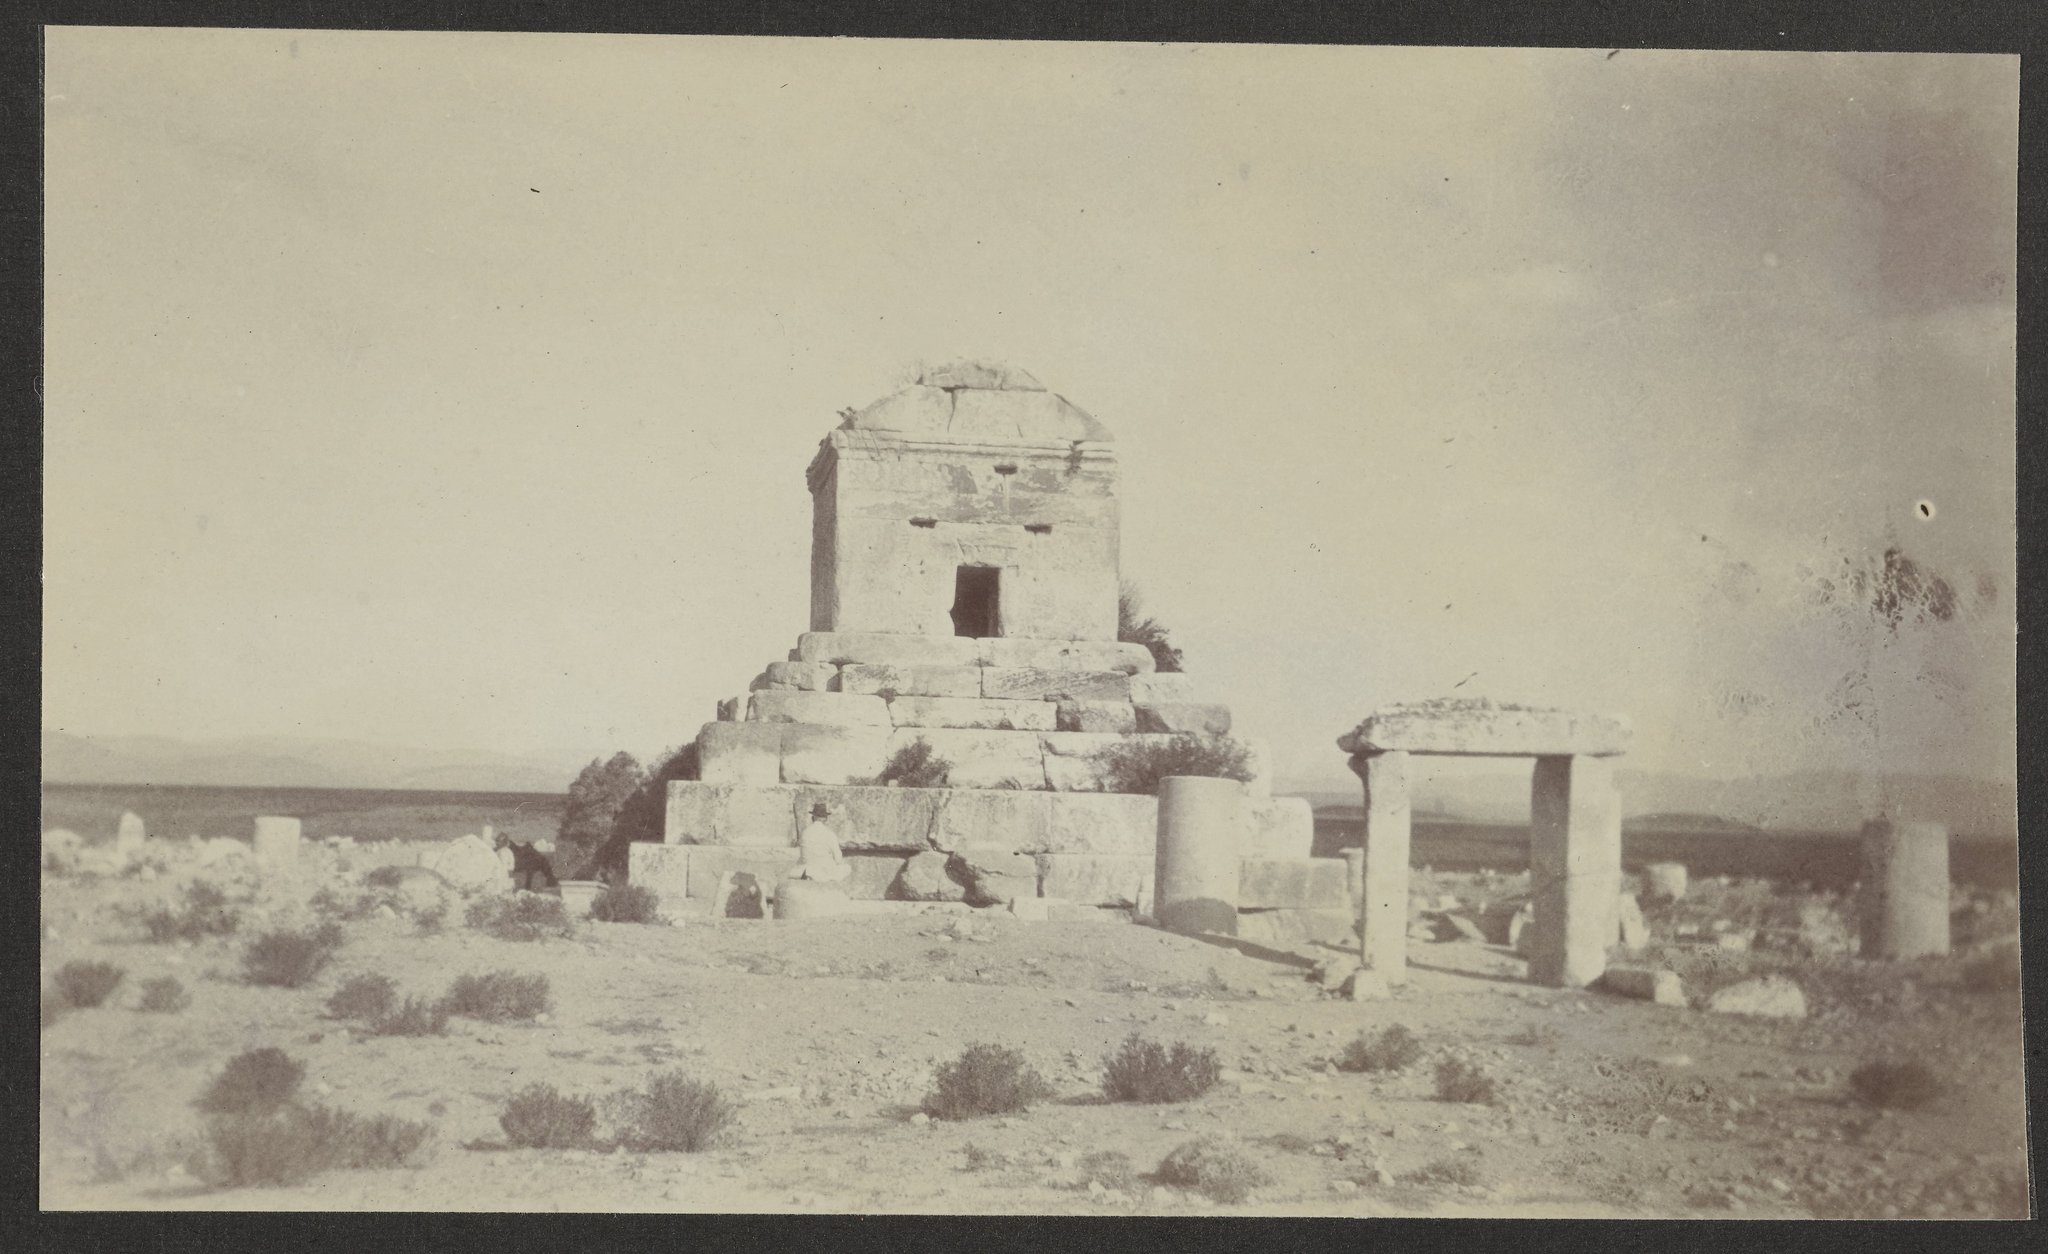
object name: photograph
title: Graf van Cyrus van een afstand gezien, Pasargadae, Perzië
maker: a.g.a. van eelde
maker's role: engineer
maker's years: 1862-1950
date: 1925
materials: cardboard, paper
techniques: gelatin silver print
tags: iran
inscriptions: number: ‘43.’